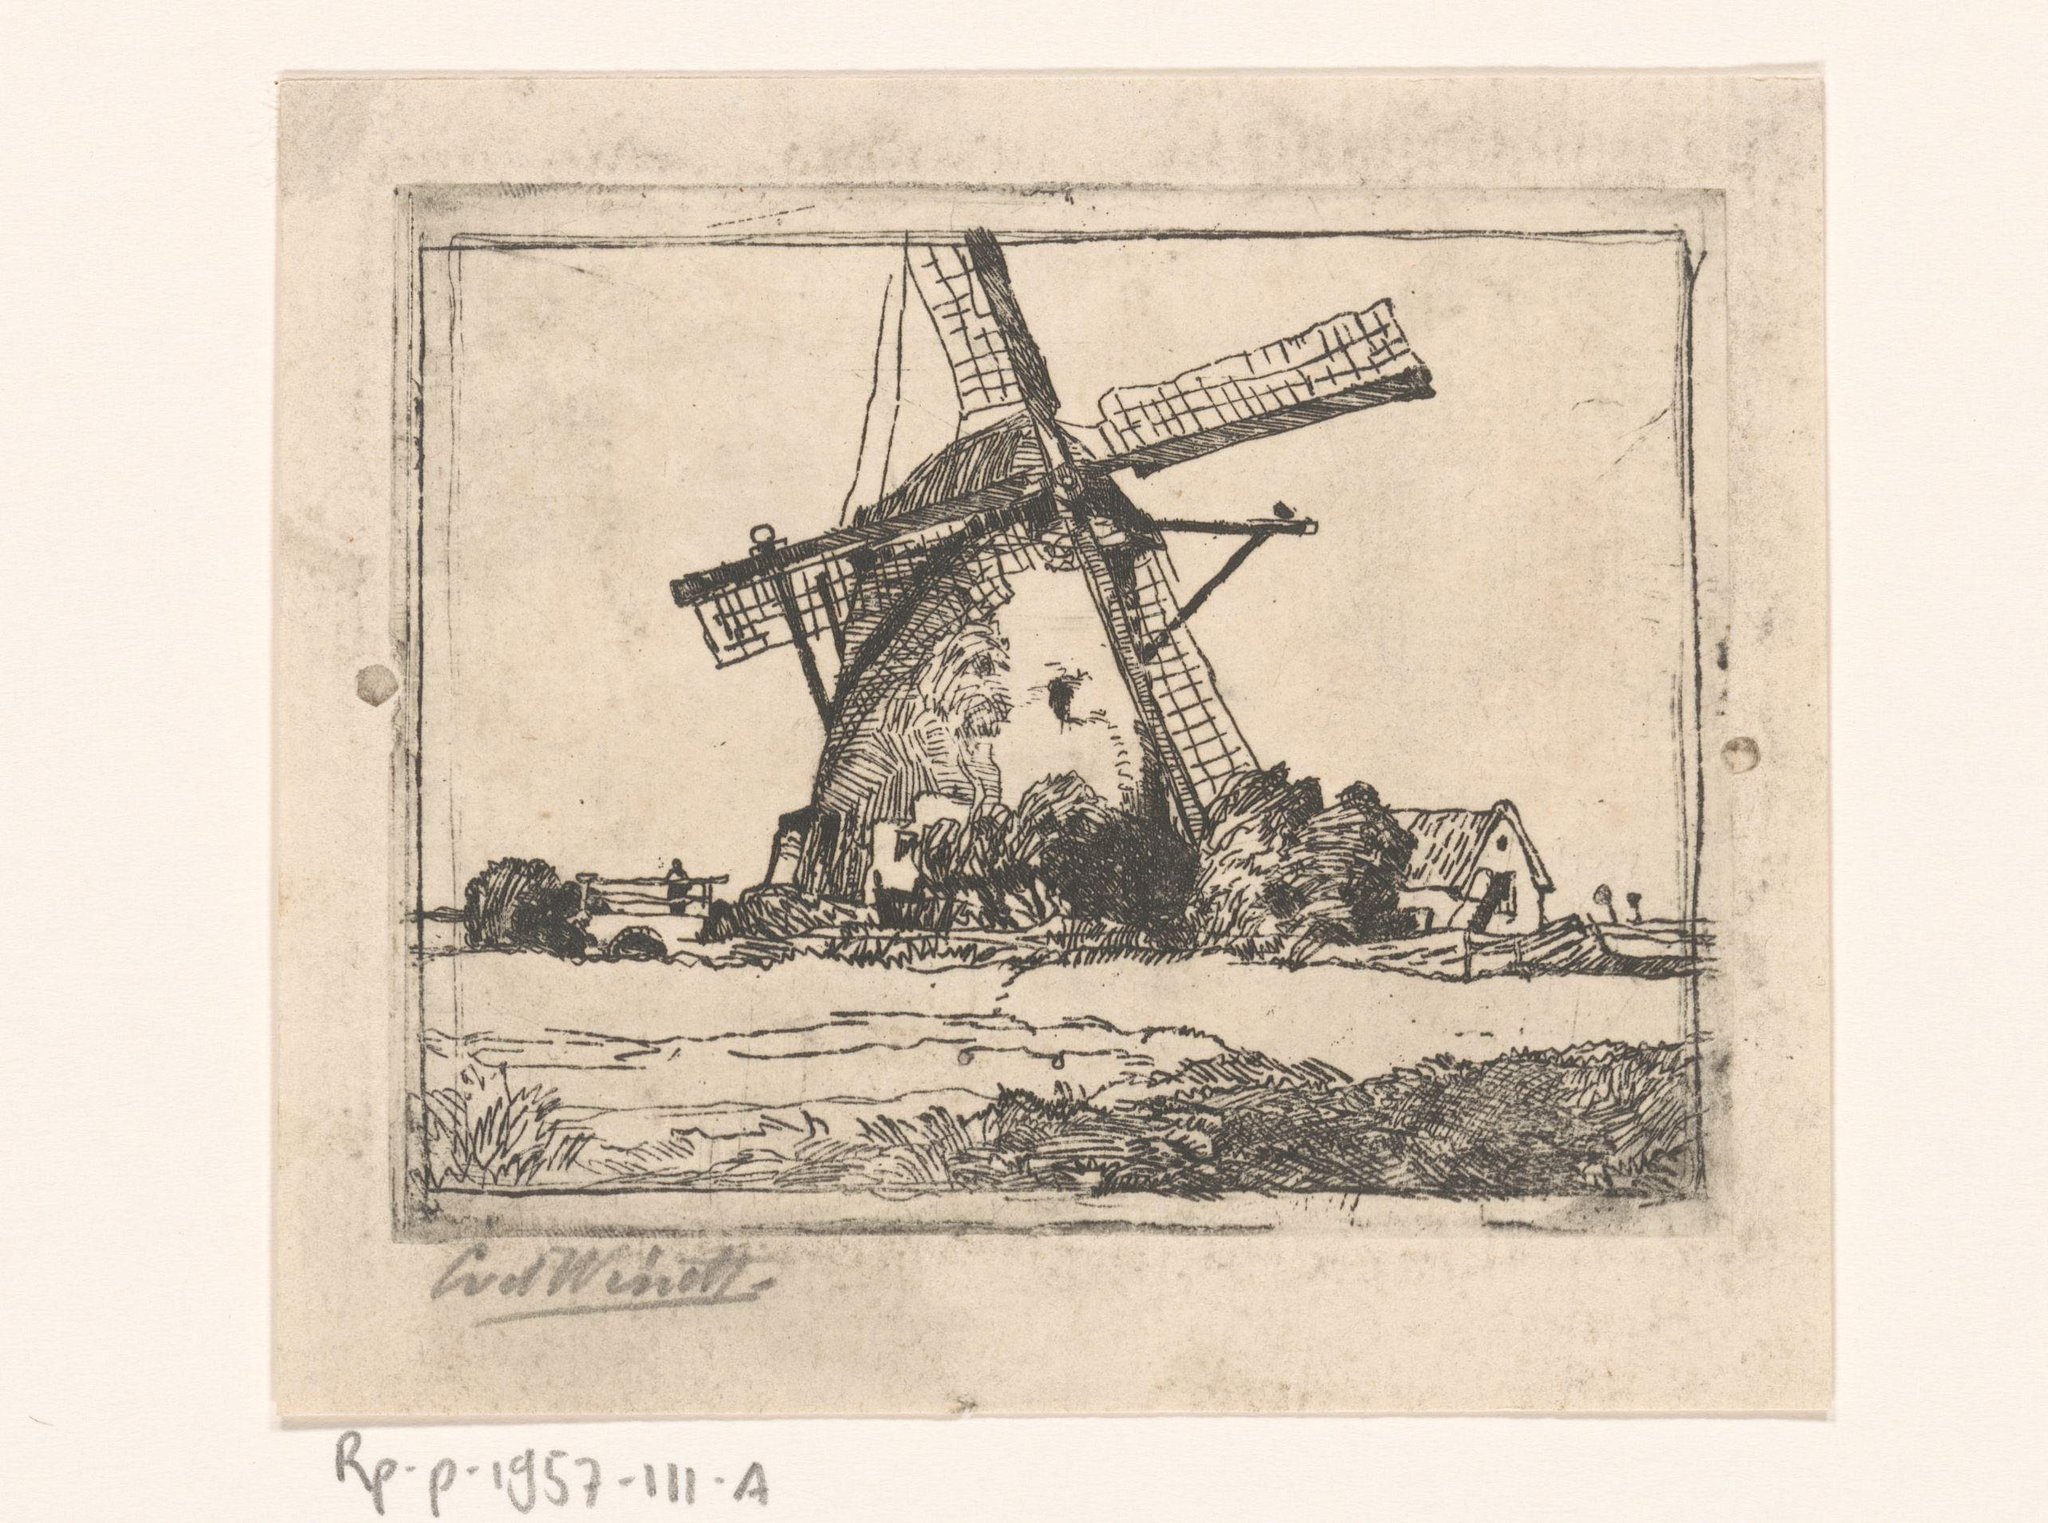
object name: print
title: Molen in een weiland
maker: chris van der windt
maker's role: print maker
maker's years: 1877-1952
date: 1887-1949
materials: paper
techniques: etching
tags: meadow, pasture, windmill in landscape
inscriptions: collector's mark: Lugt 2228